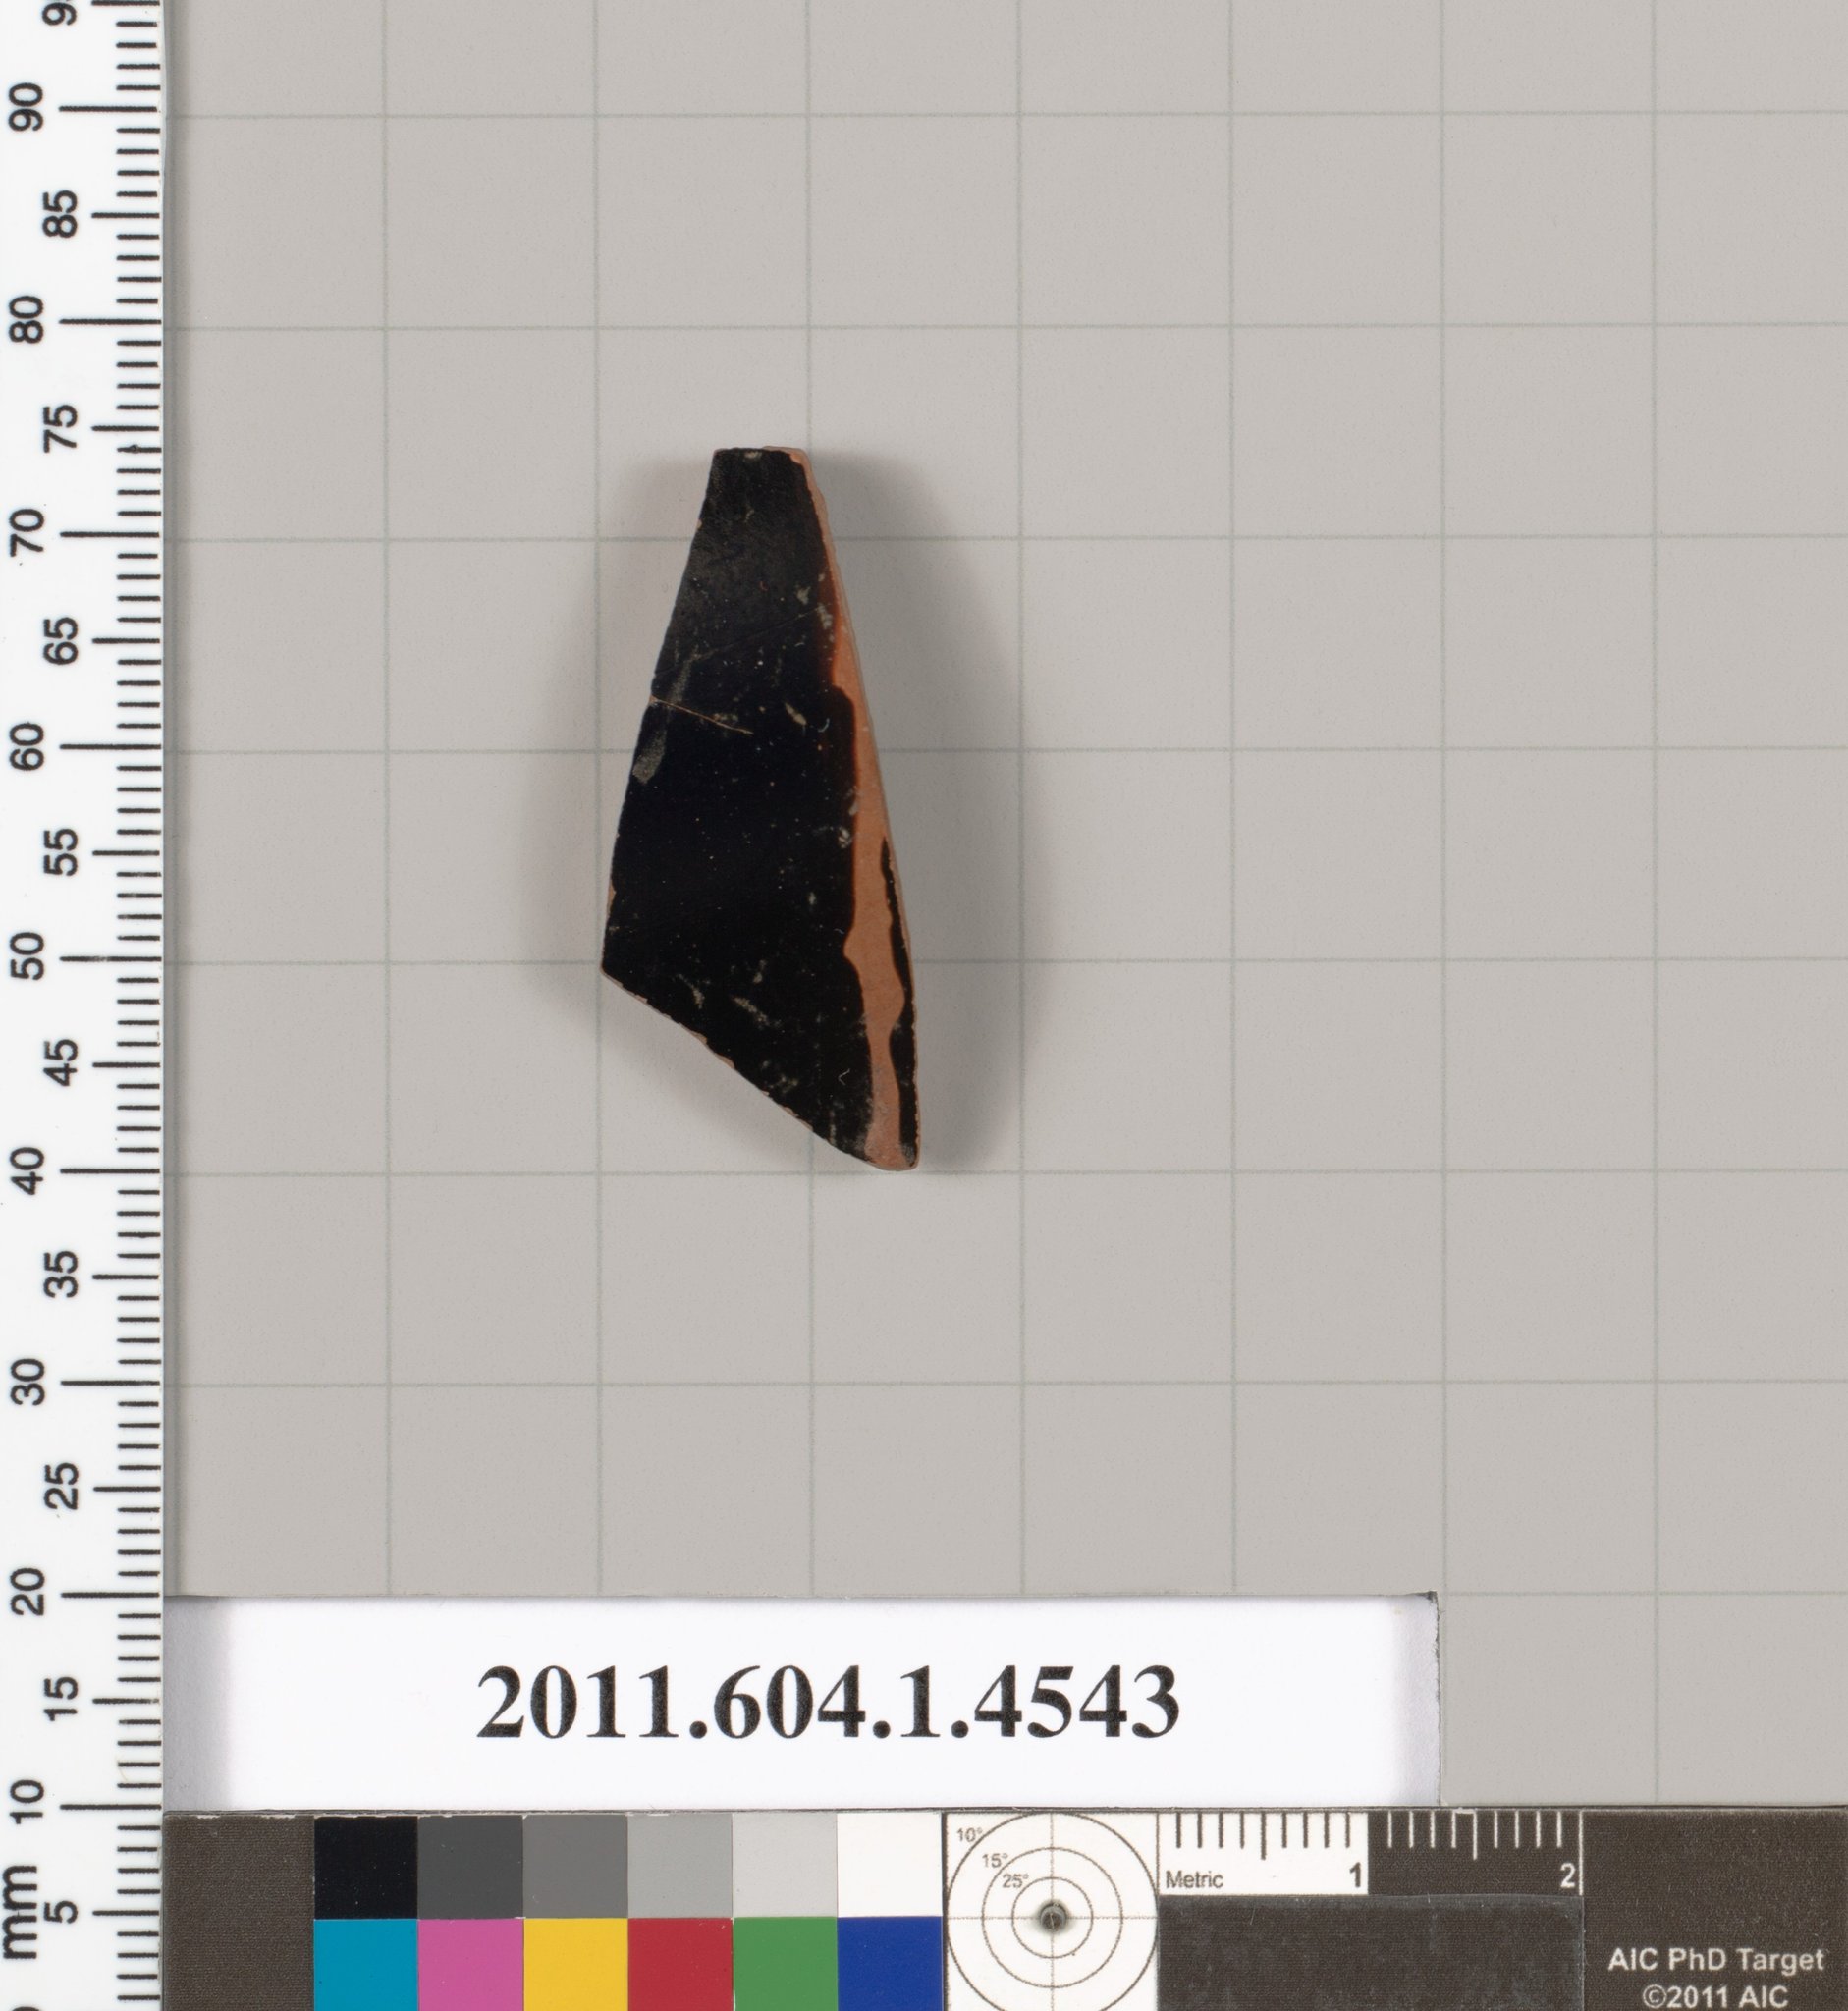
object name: kylix fragment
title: Terracotta fragment of a kylix (drinking cup)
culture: greek, attic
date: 500-451 BCE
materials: terracotta